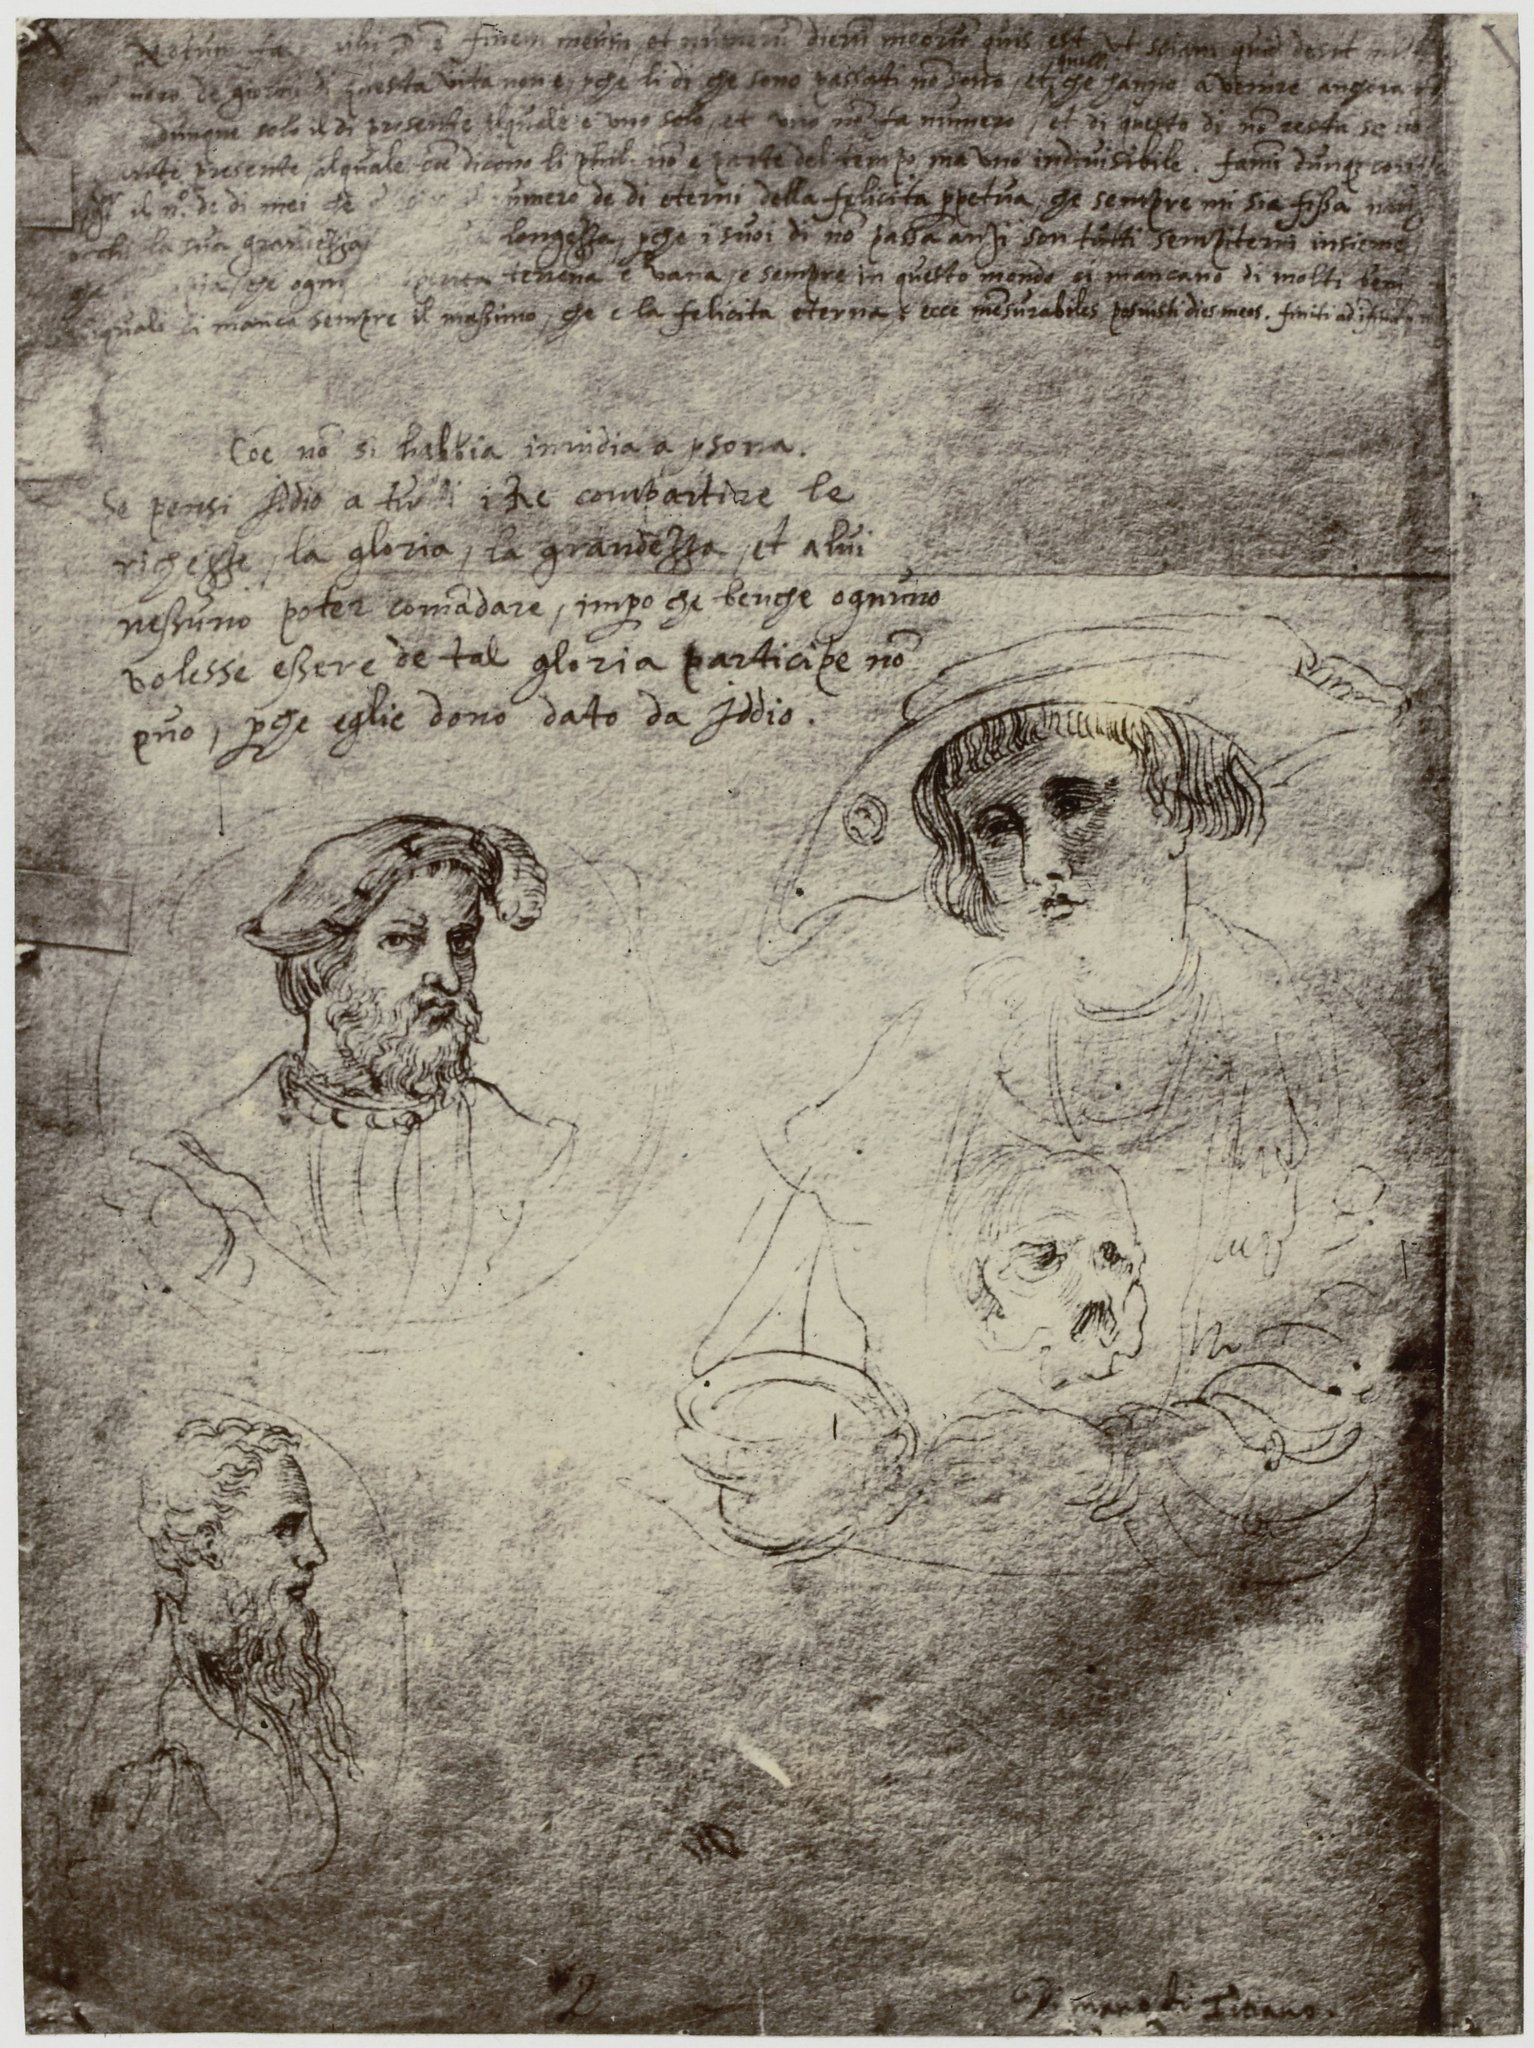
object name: photograph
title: Titiaan, Sketch of Heads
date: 1855-1858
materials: cardboard, paper, photographic support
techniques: albumen print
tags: drawing, sketch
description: Fotoreproductie van tekening in 'The Reveley Collection of Drawings at Brynygwin', afb. 43.